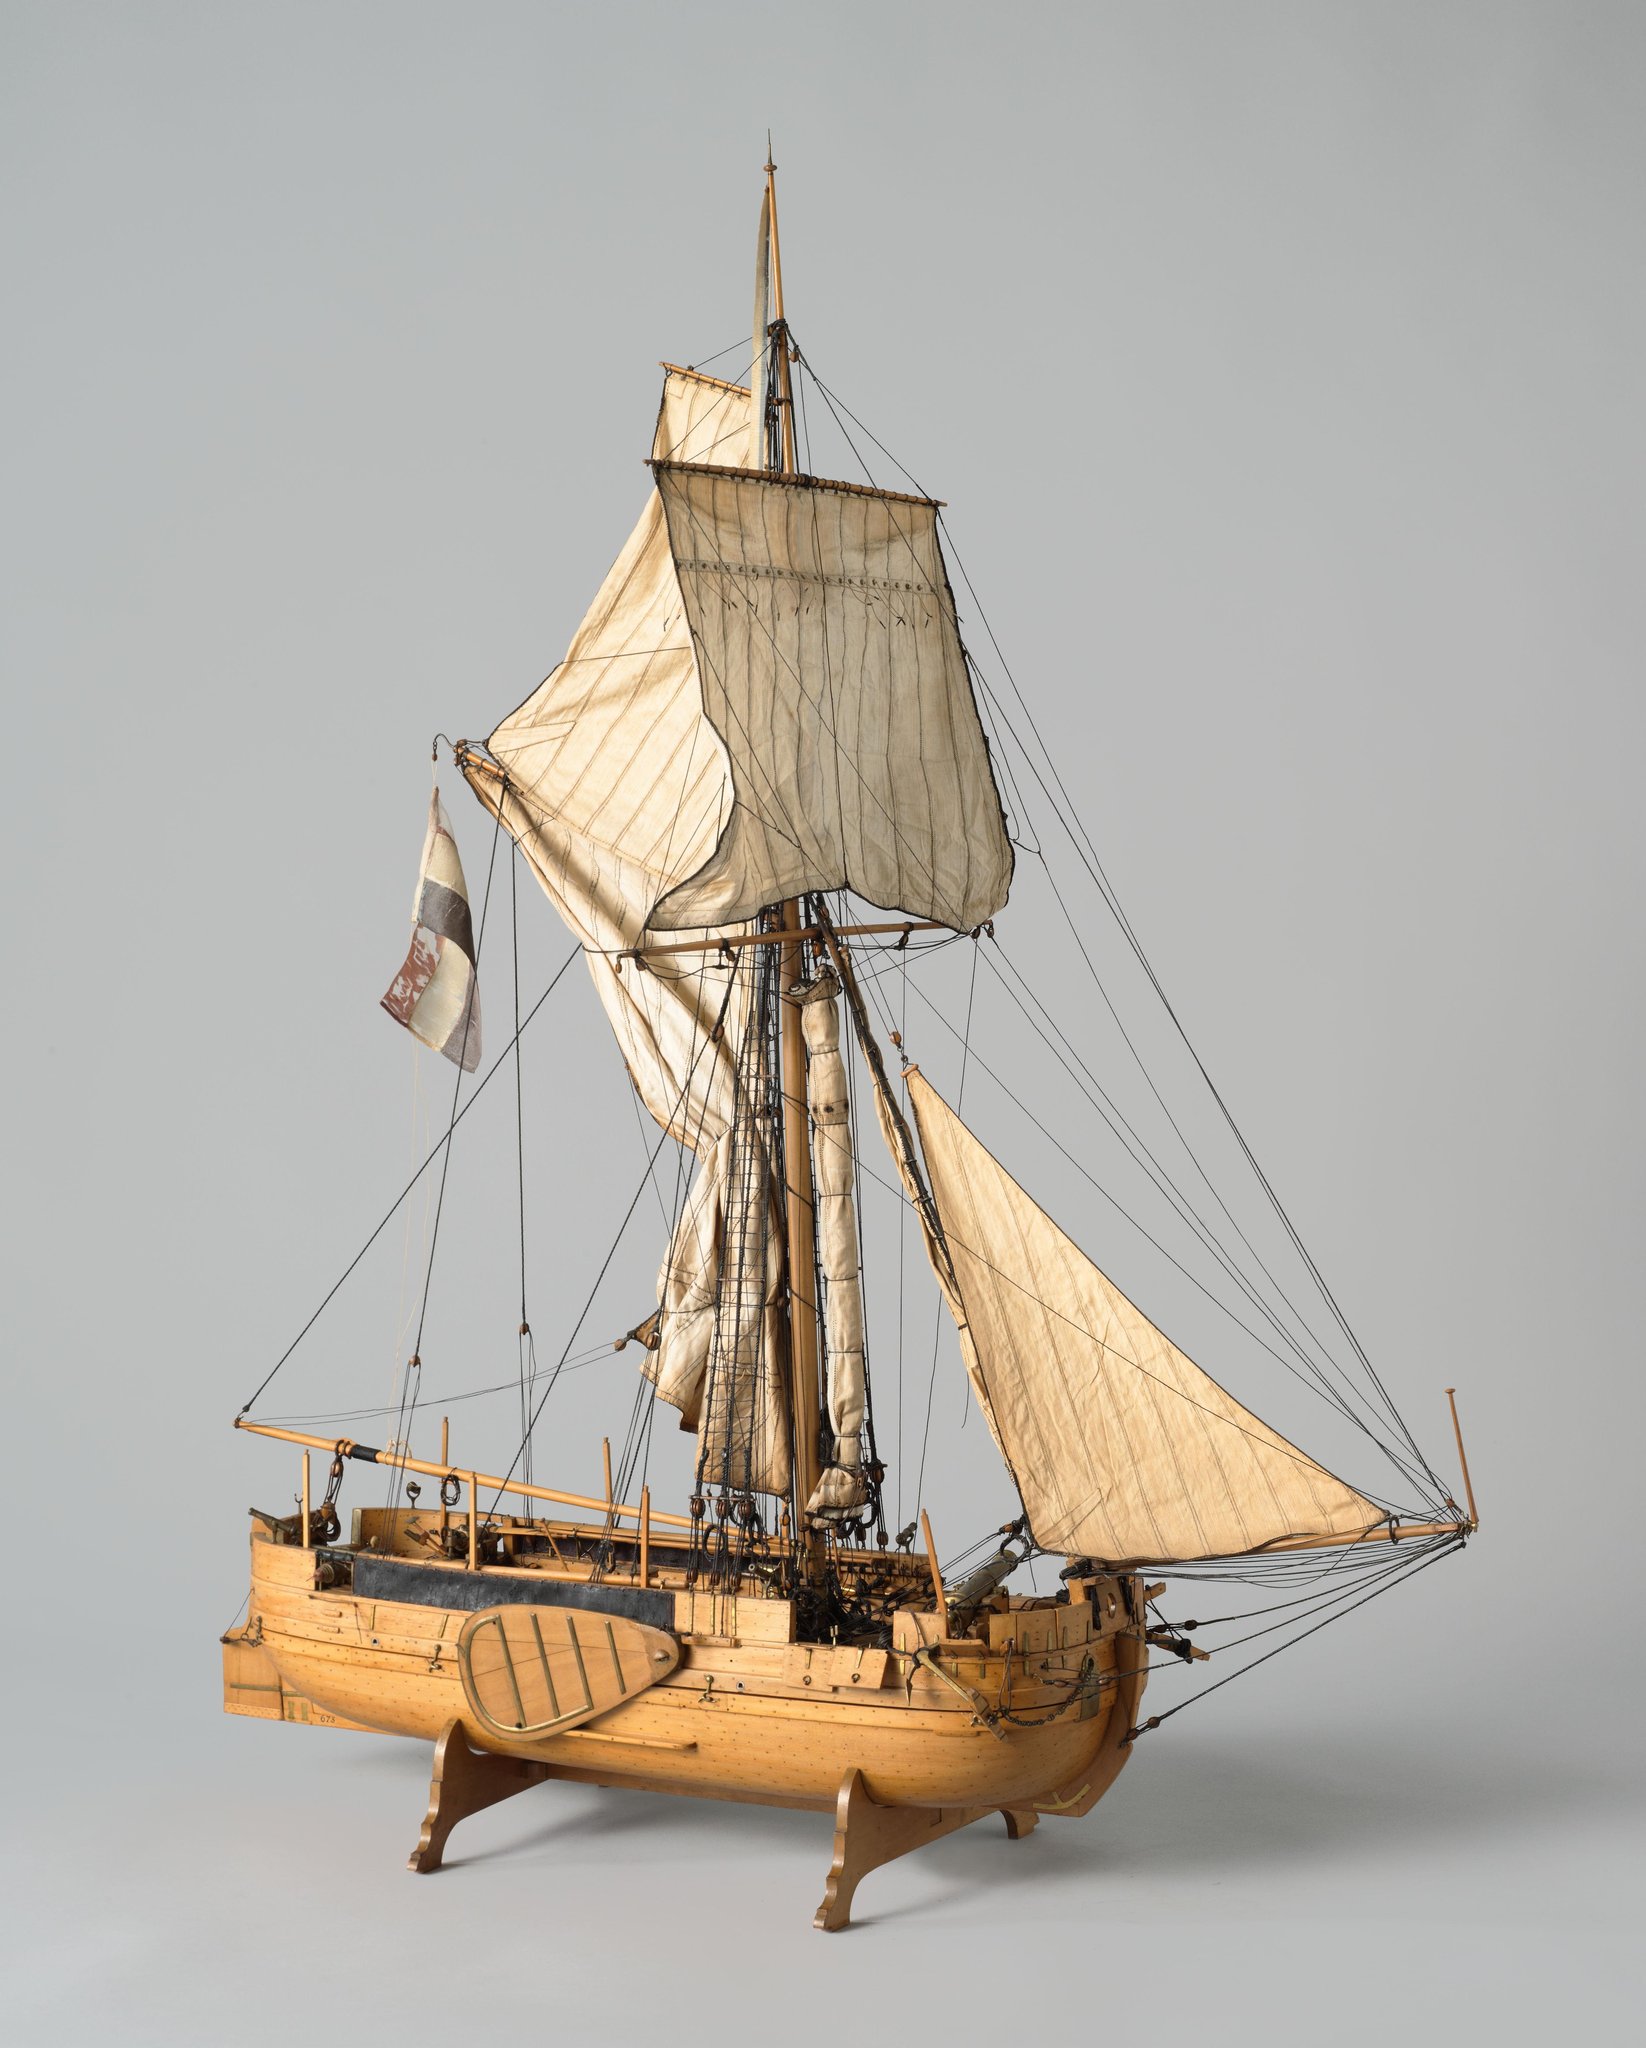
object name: fully rigged model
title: Model of a gaff-rigged gunboat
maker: Anonymous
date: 1835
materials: brass, bronze, lead, fiber, textile, wood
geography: rotterdam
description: Gunboats were deployed by the navies of various countries to protect their estuaries and rivers. This model represents the largest type used by the Royal Netherlands wNavy, the gaff-rigged gunboat. A number of them were used in the blockade of Antwerp during the Belgian Revolt. Gunboat No. 2 became the most famous when Lieutenant Jan van Speijk blew up the vessel in 1831, rather than risk its capture by Belgian insurgents.